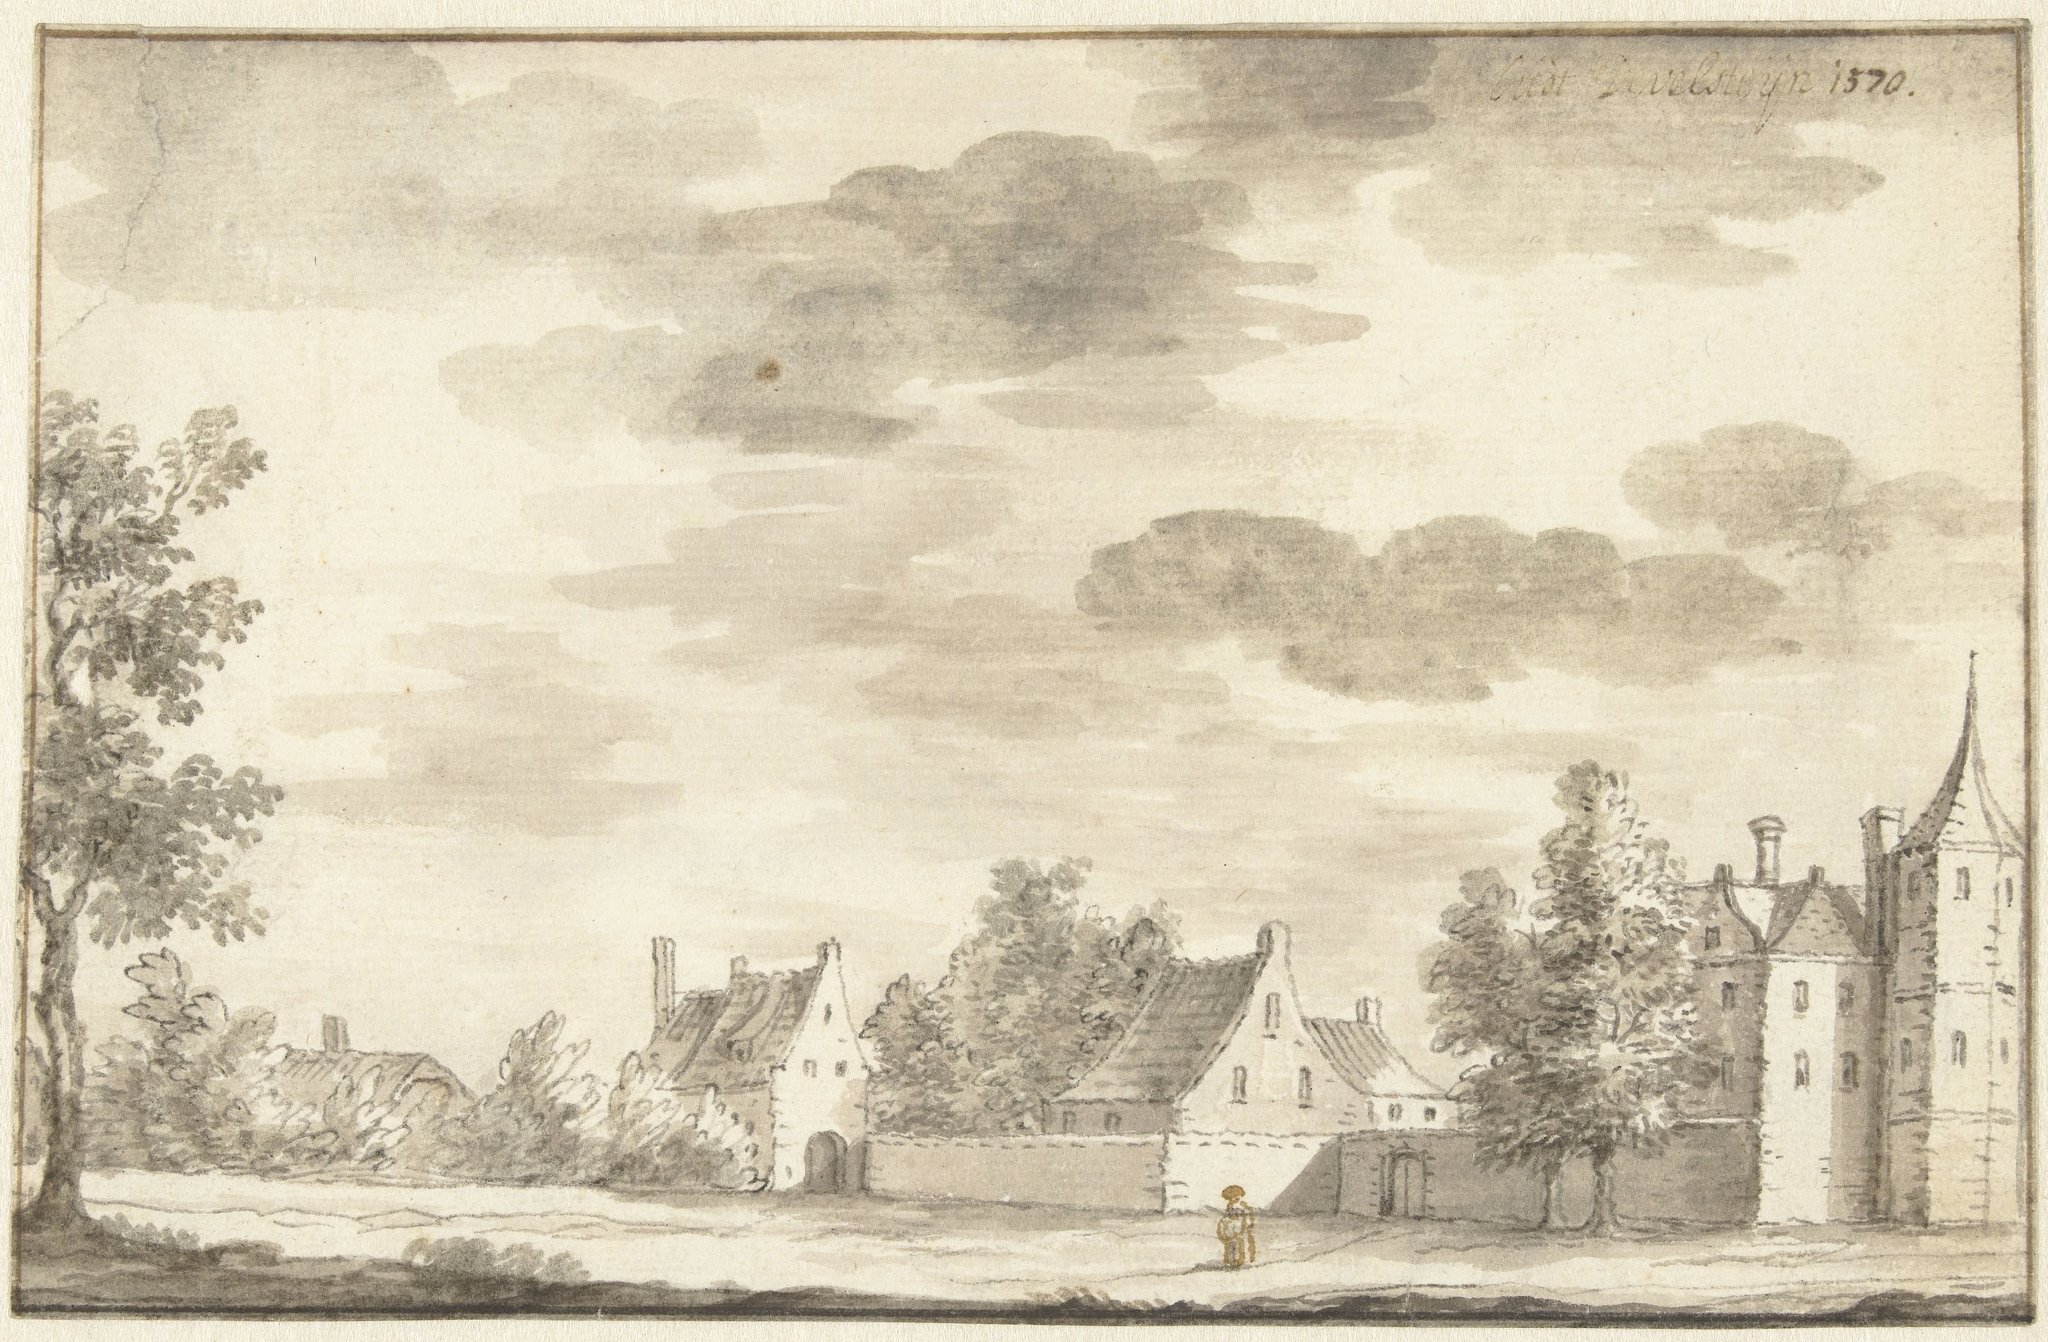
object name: drawing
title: Kasteel Oud-Develstein bij Zwijndrecht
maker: joseph adolf schmetterling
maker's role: draughtsman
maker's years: 1751-1828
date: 1761-1828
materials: ink, paper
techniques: brush, pen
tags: castle, rural housing, e.g. country-house, villa, cottage